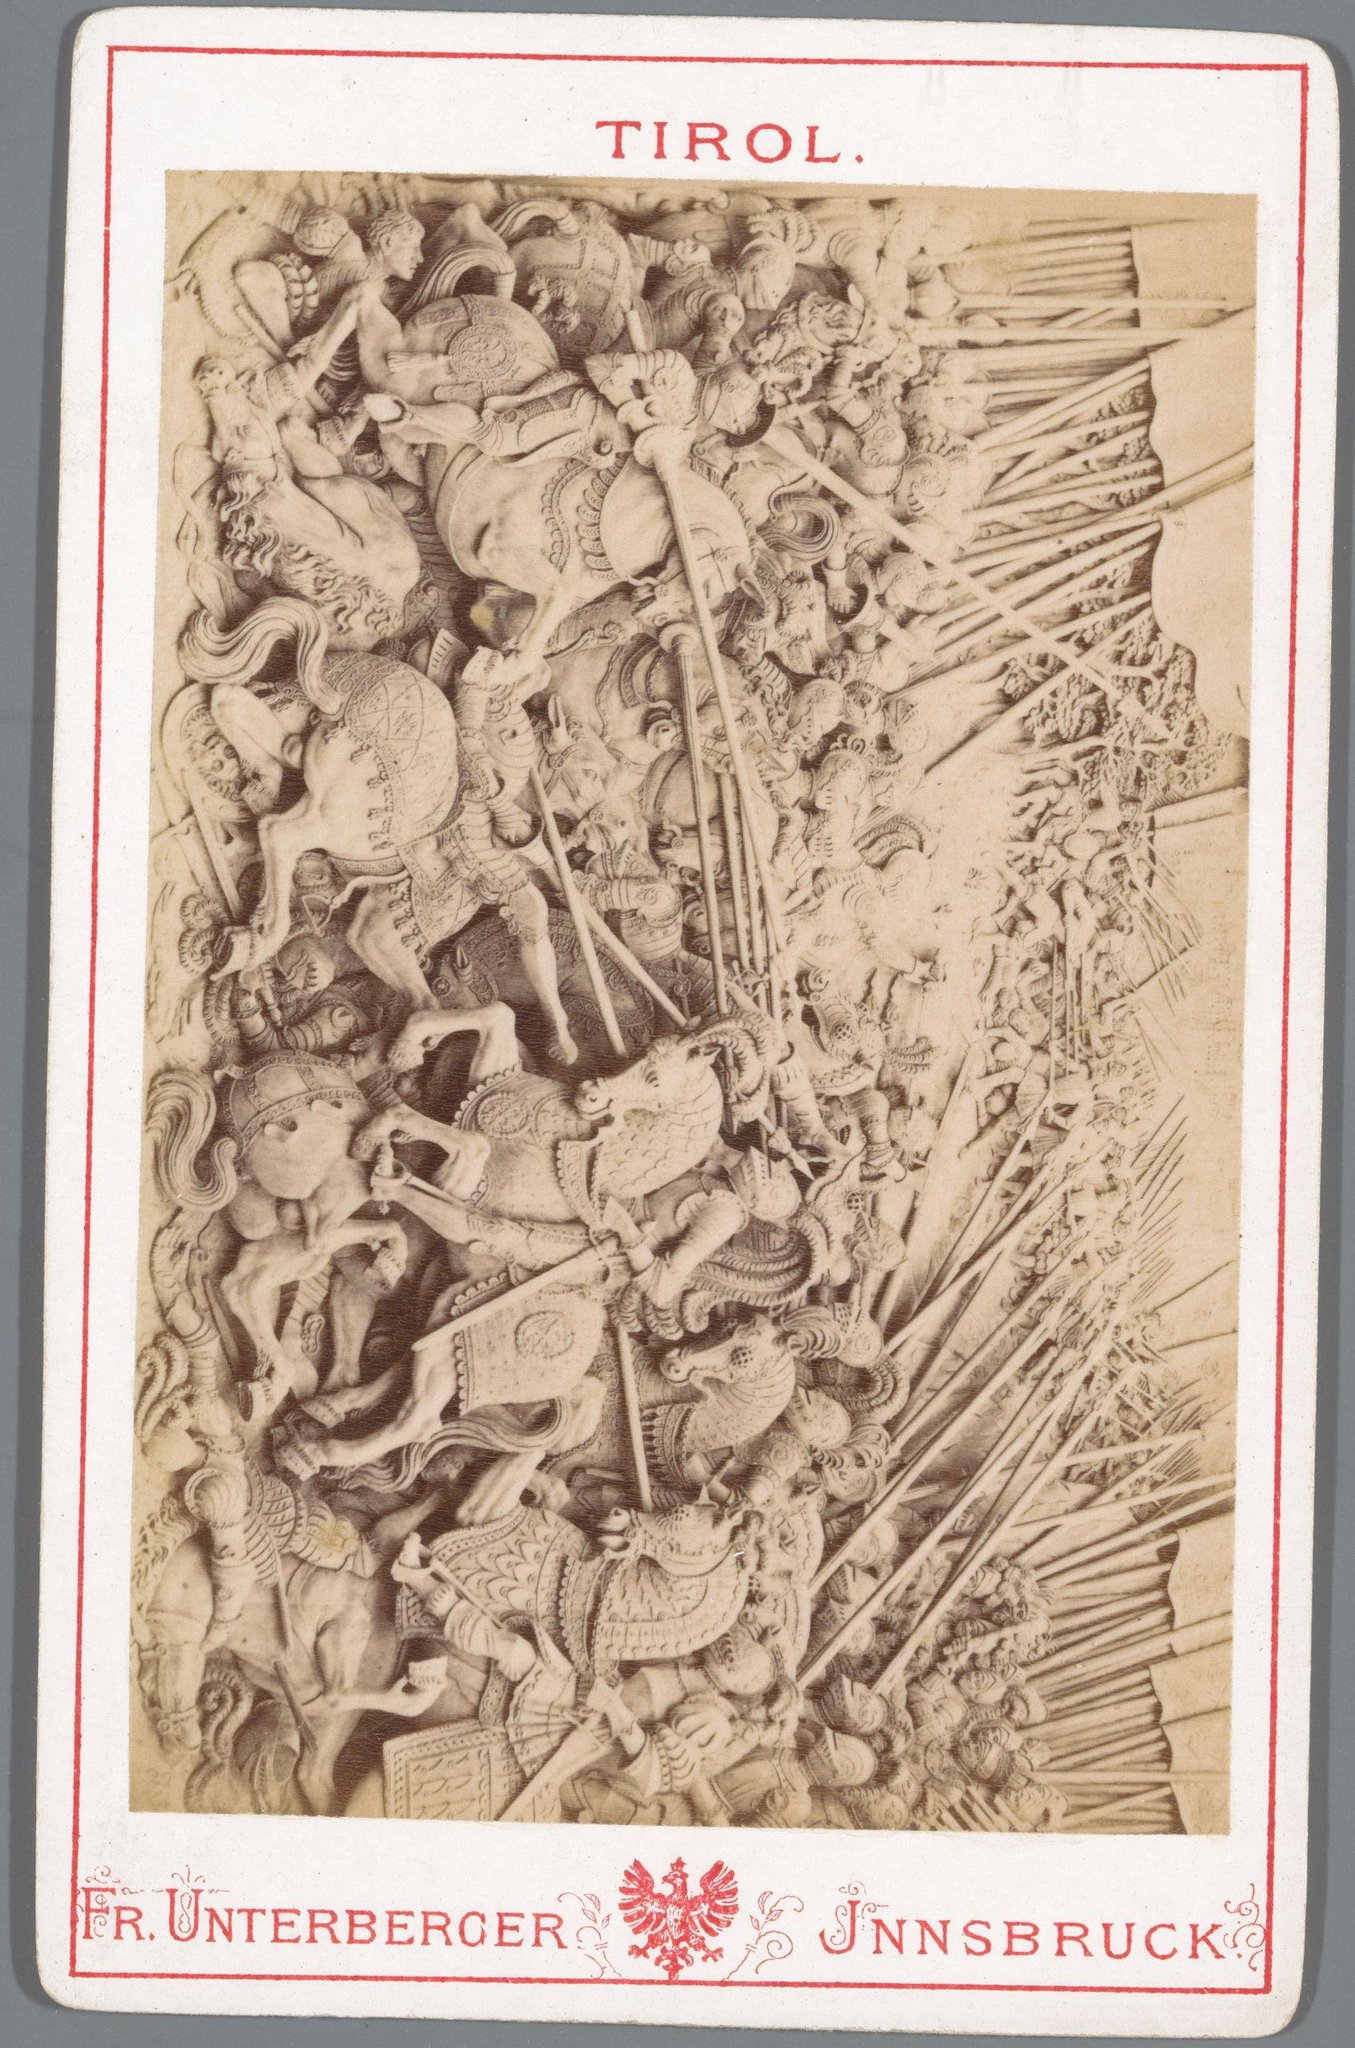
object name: carte de visite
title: Tirol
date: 1855-1867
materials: cardboard, paper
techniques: albumen print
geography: innsbruck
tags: battle, grave, tomb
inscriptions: number: ‘19.’